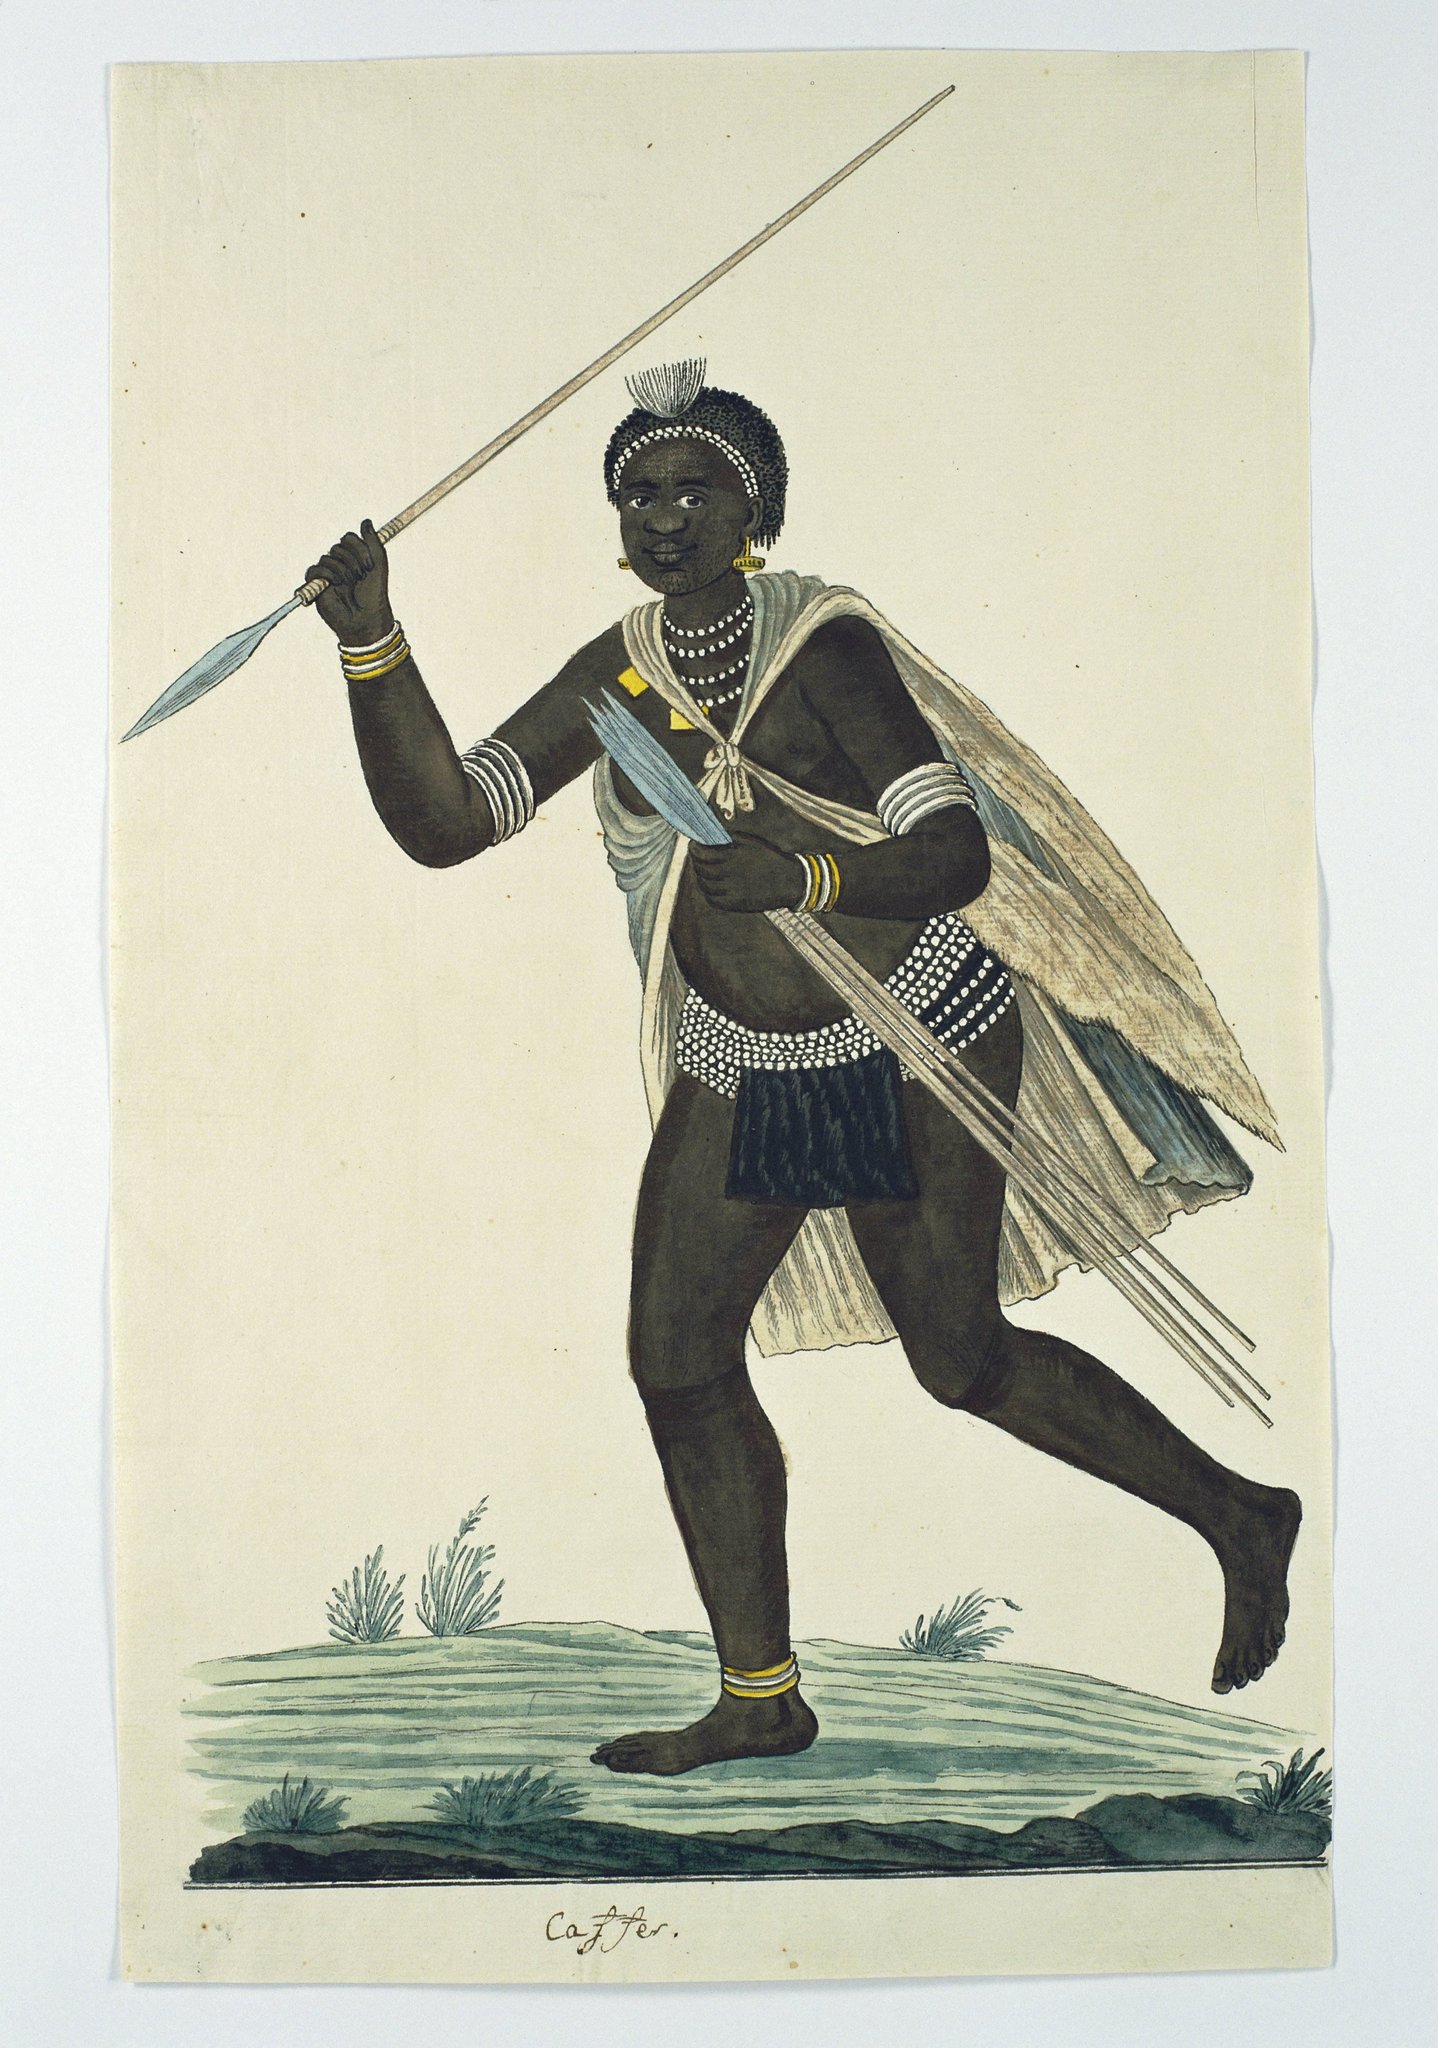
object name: drawing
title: Running man holding an assegai in his right hand and four assegais in his left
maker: robert jacob gordon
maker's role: draughtsman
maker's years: 1743-1795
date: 1776-1795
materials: paint, ink, paper, watercolor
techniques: brush, pen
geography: cape of good hope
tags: cape of good hope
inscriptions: annotation, lower margin, handwritten in brown ink: ‘Caffer’ hand Sch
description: Xhosa met jachtgereedschap